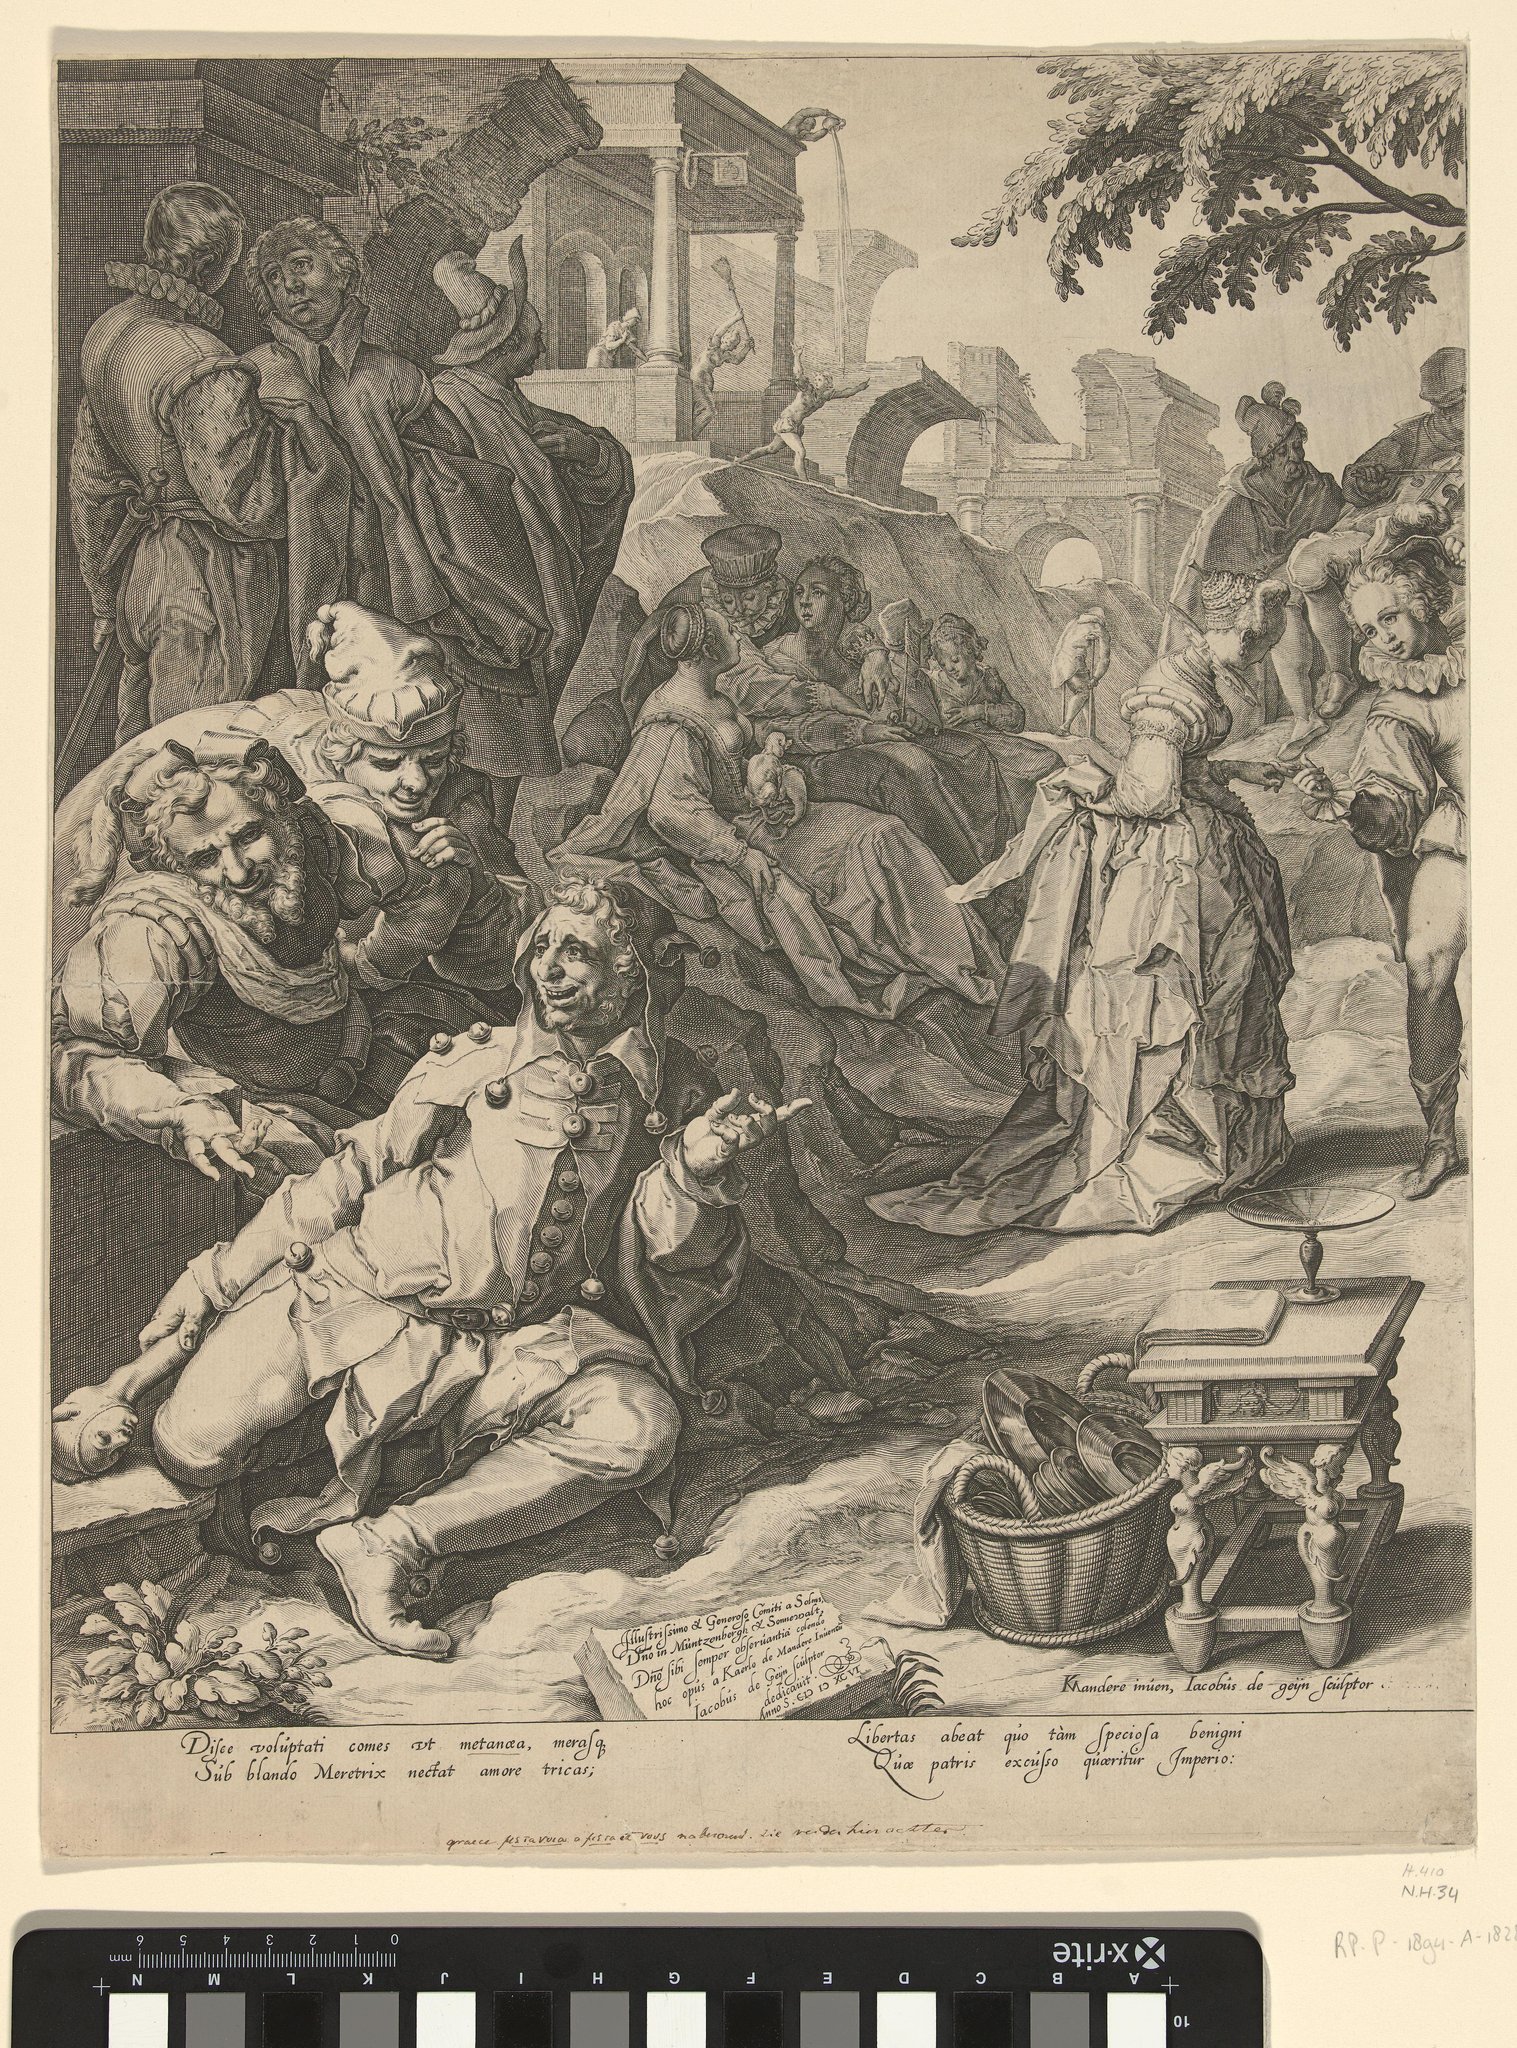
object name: print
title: De verloren zoon (linkerblad)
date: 1596-1760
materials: paper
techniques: engraving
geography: leiden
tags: the parable of the prodigal son (luke 15:11-32)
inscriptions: inscription: ‘graece metanoia [...] na berouw. Zie verder hier achter’ Opmerking heeft betrekking op een woord in het onderschrift., collector's mark: Lugt 2228a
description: Linkerdeel van een voorstelling op twee bladen van een gezelschap dat zich in de buitenlucht vermaakt met eten, drinken, muziek en vrijages. Op de achtergrond is te zien hoe een man weggejaagd wordt uit een gebouw. Onder de voorstelling de eerste vier regels van een achtregelig Latijns gedicht.